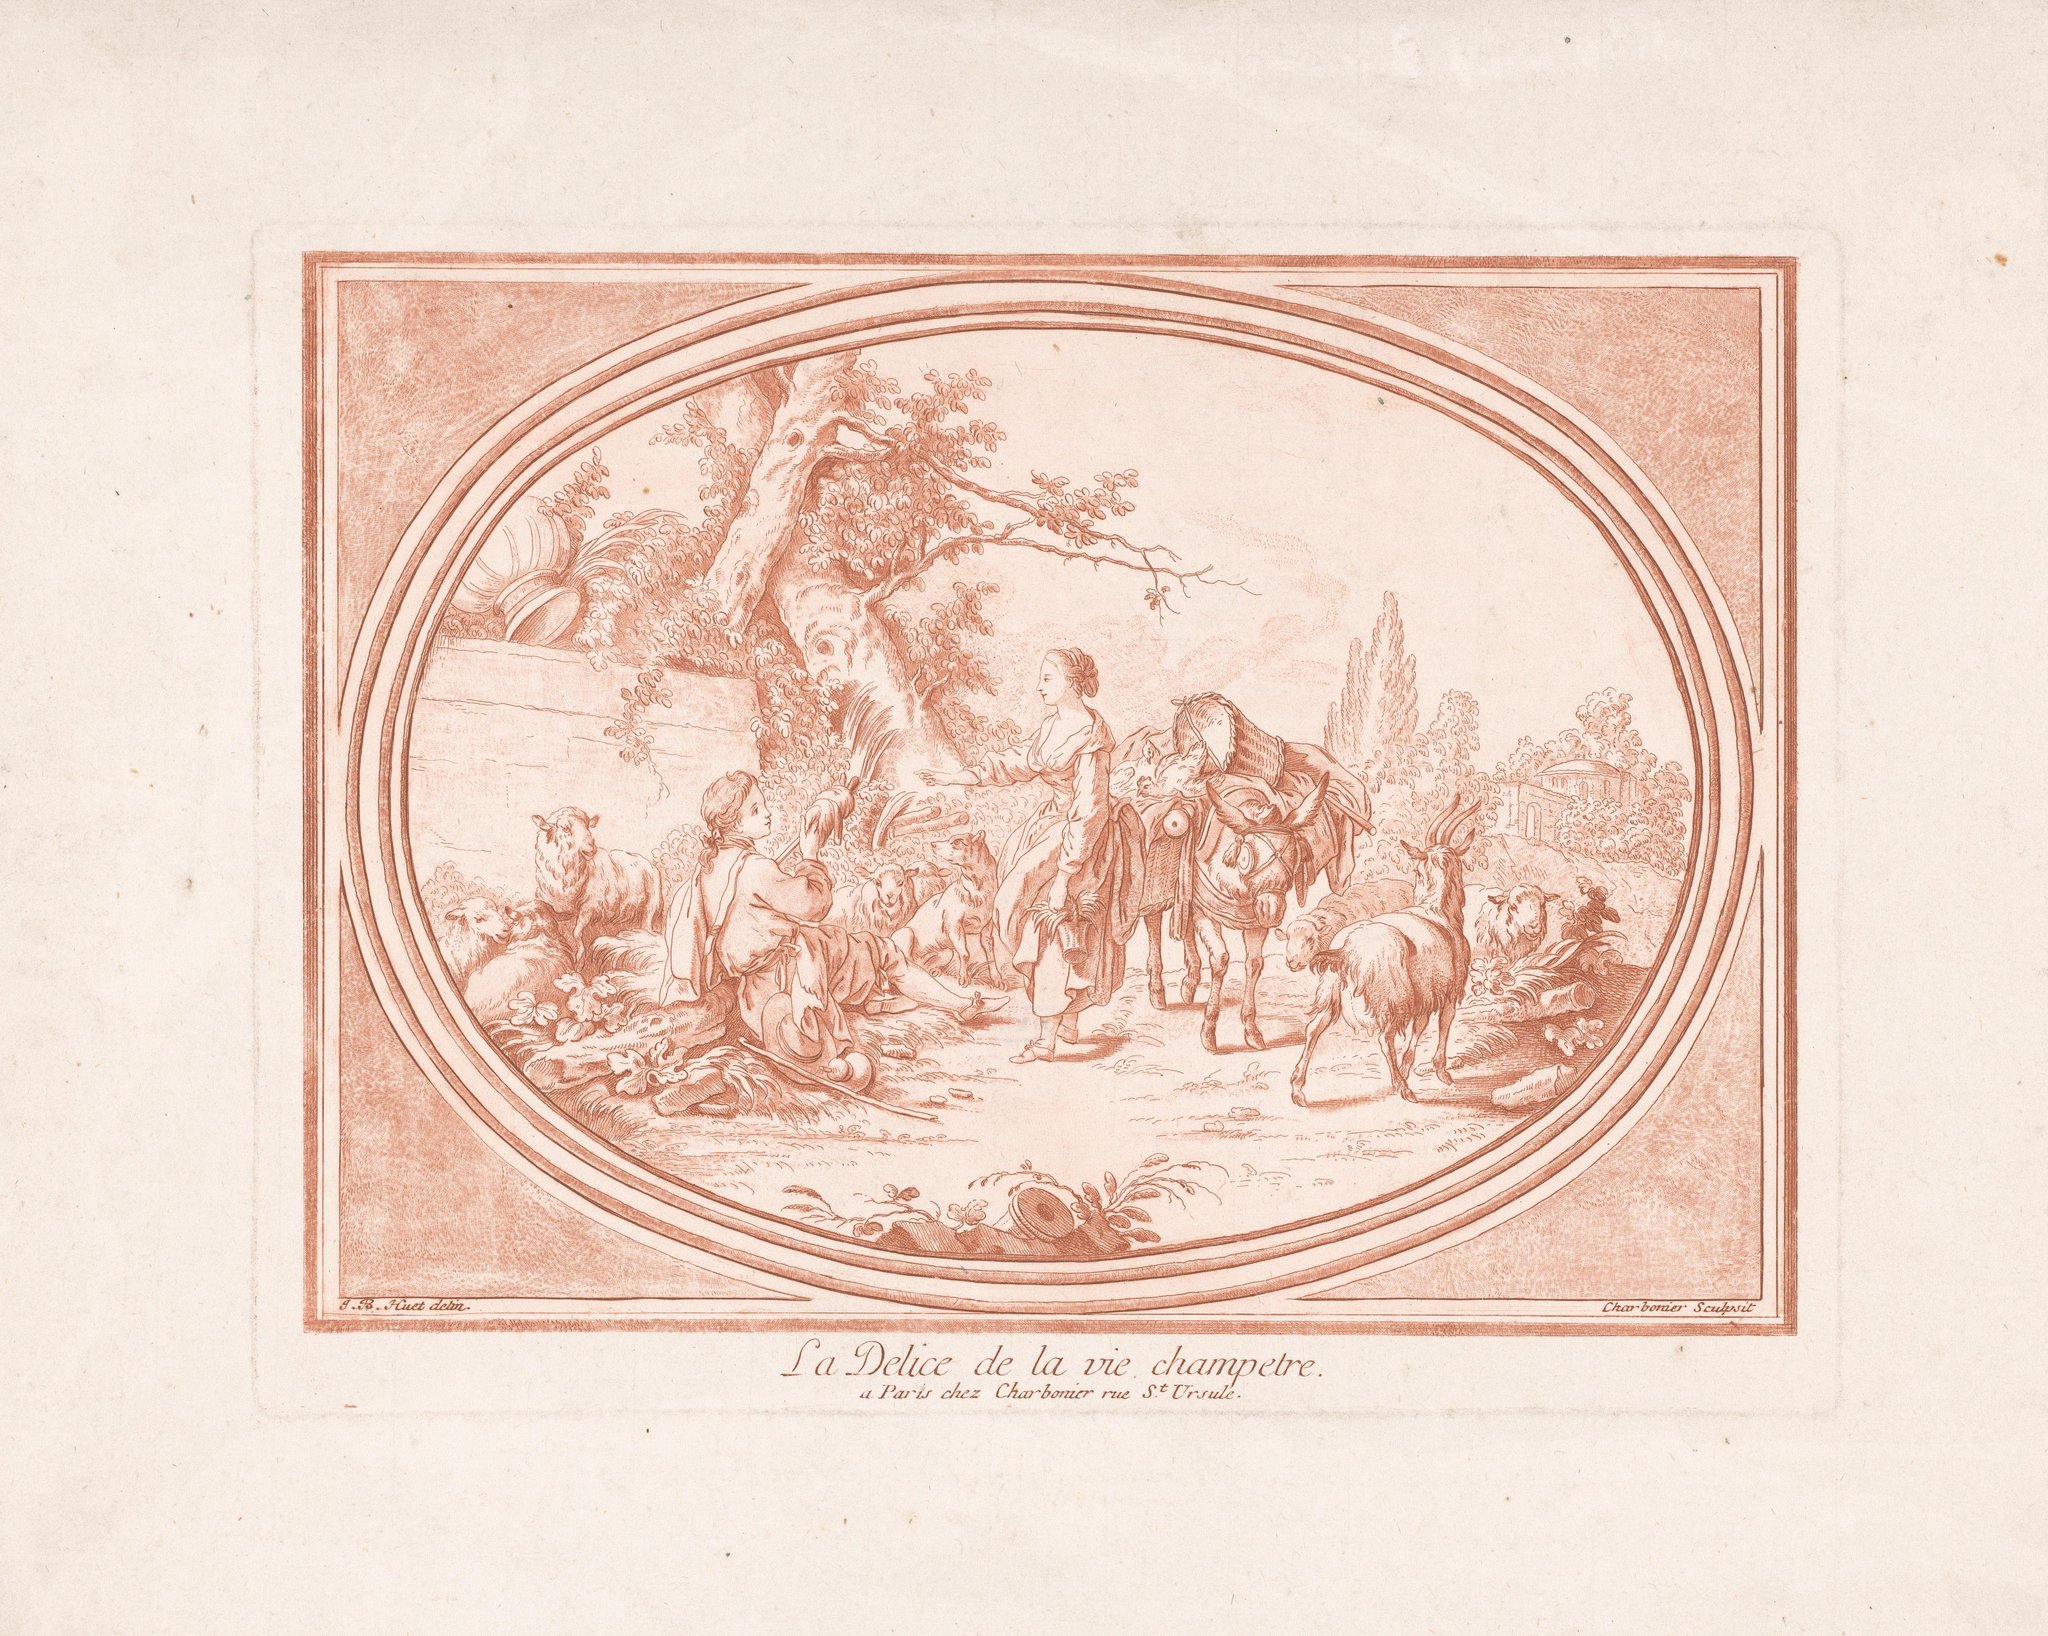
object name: print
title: Landschap met een herder en een jonge vrouw met een pakezel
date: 1700-1799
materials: paper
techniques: printmaking, etching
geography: france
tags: ass, donkey, herding, herdsman, herdswoman, shepherd, shepherdess, cowherd, etc., herd, flock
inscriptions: collector's mark: Lugt 2228